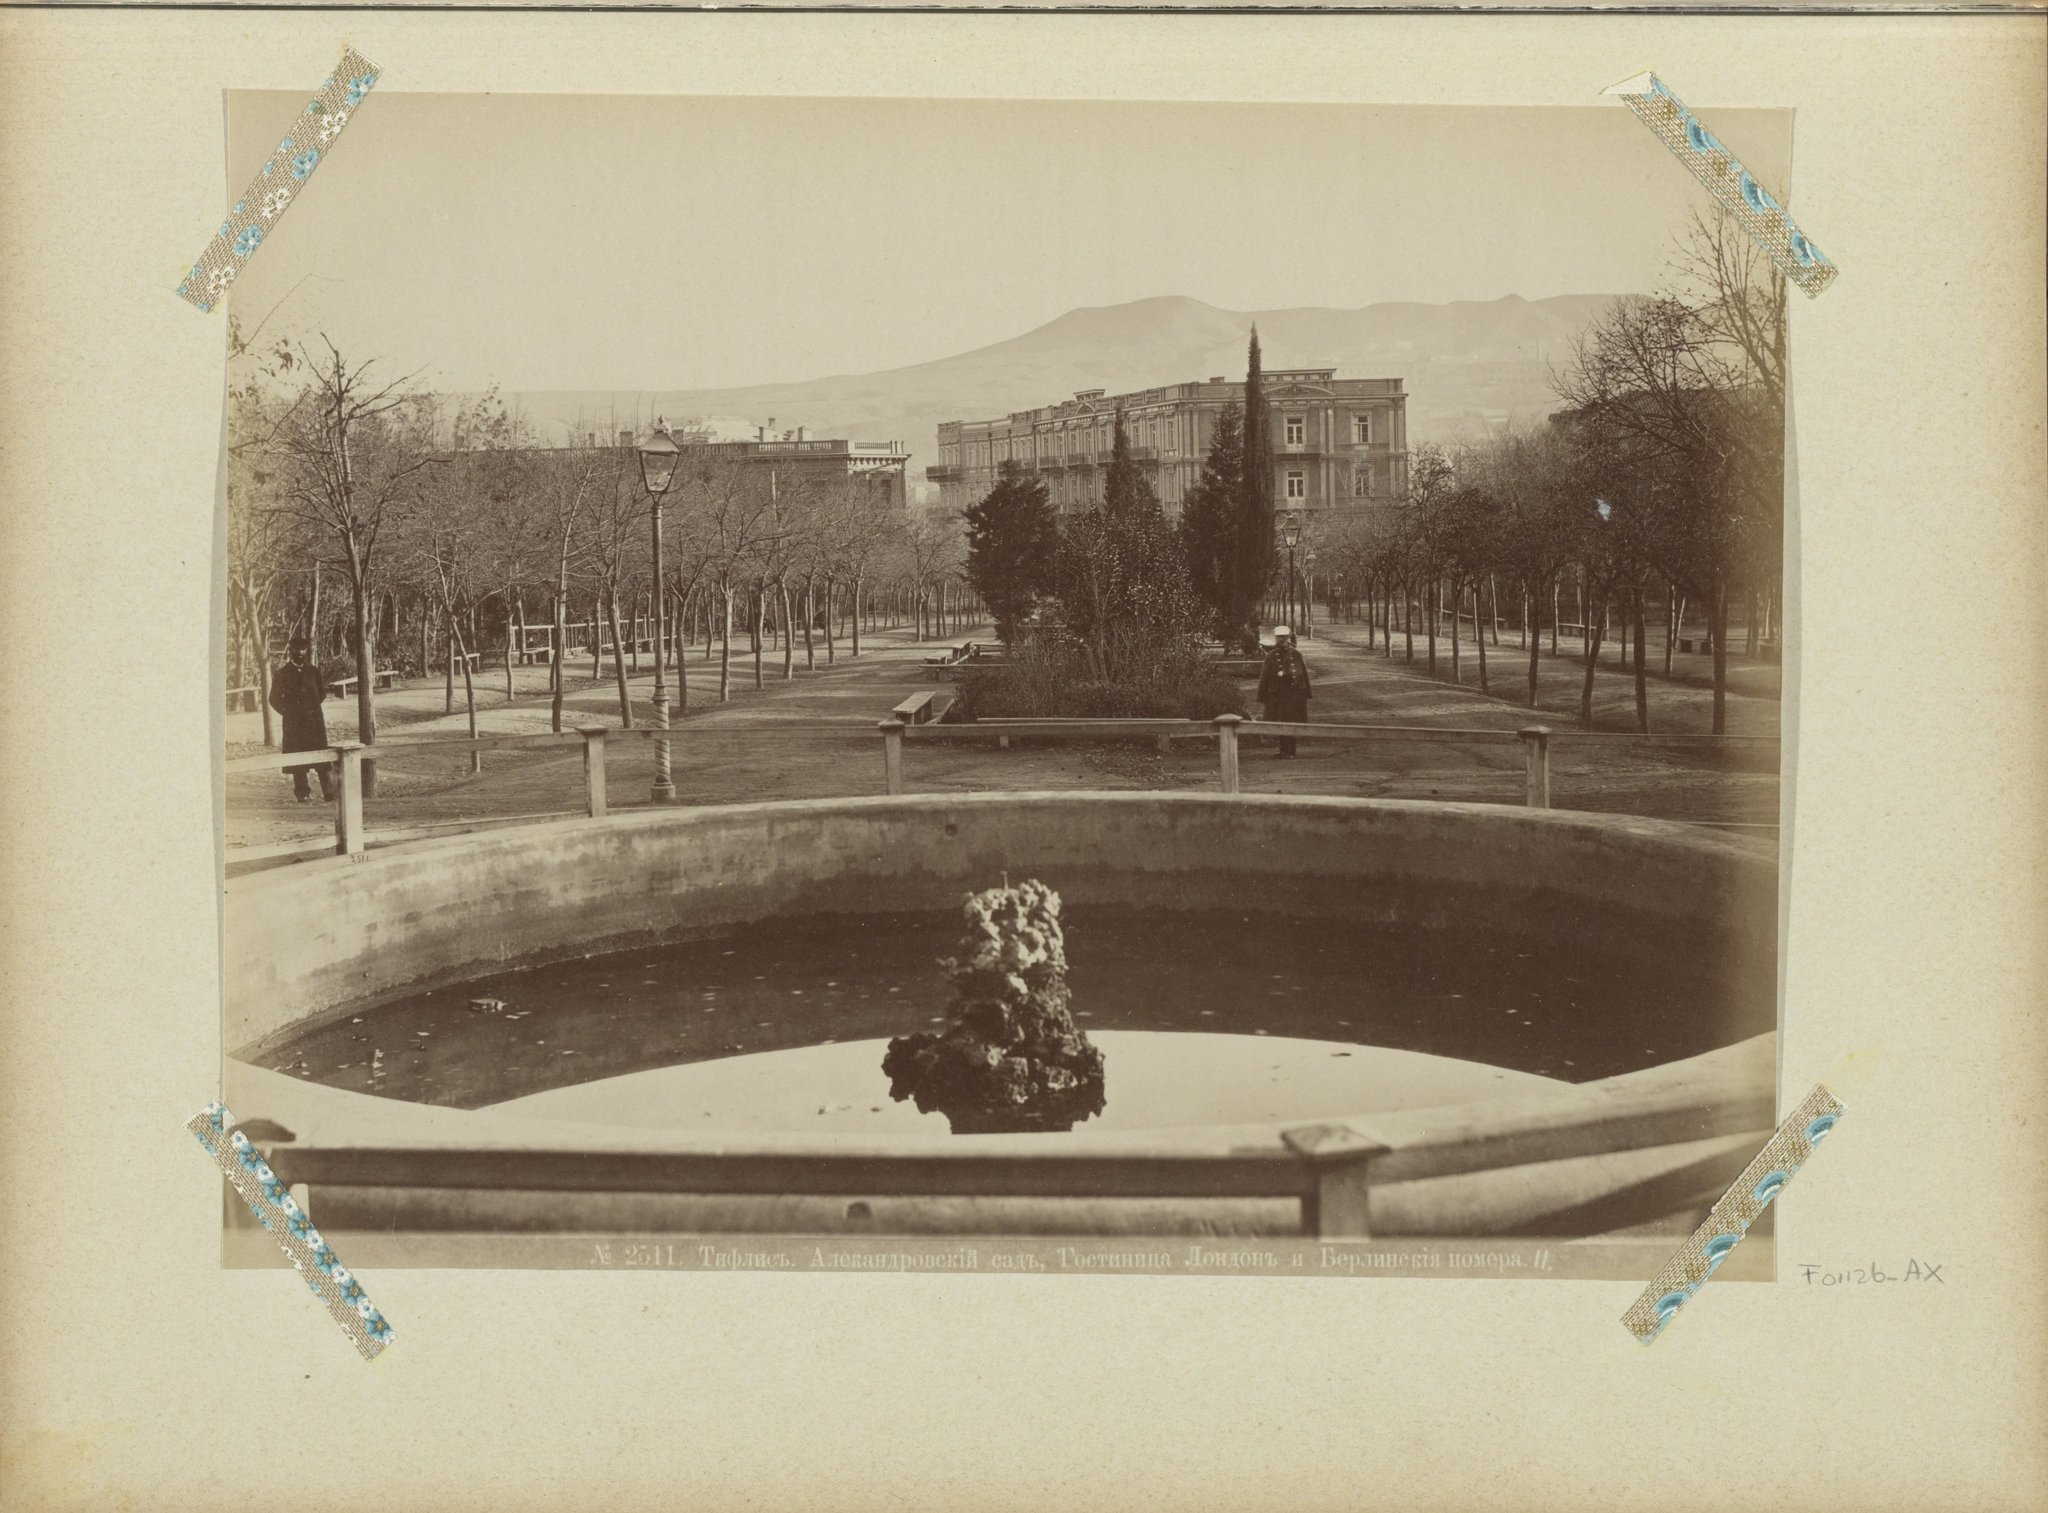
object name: photograph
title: Tiflis, Alekandrowski sad, Gostinitsja London i Berlinskija nomjora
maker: Anonymous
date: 1890-1900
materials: photographic support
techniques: albumen print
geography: tbilisi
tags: garden, hotel, hostelry, inn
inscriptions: number: ‘11’, number: ‘2511’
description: Onderdeel van Fotoalbum met opnames van bezienswaardigheden in Georgië, Sint-Petersburg en Moskou.